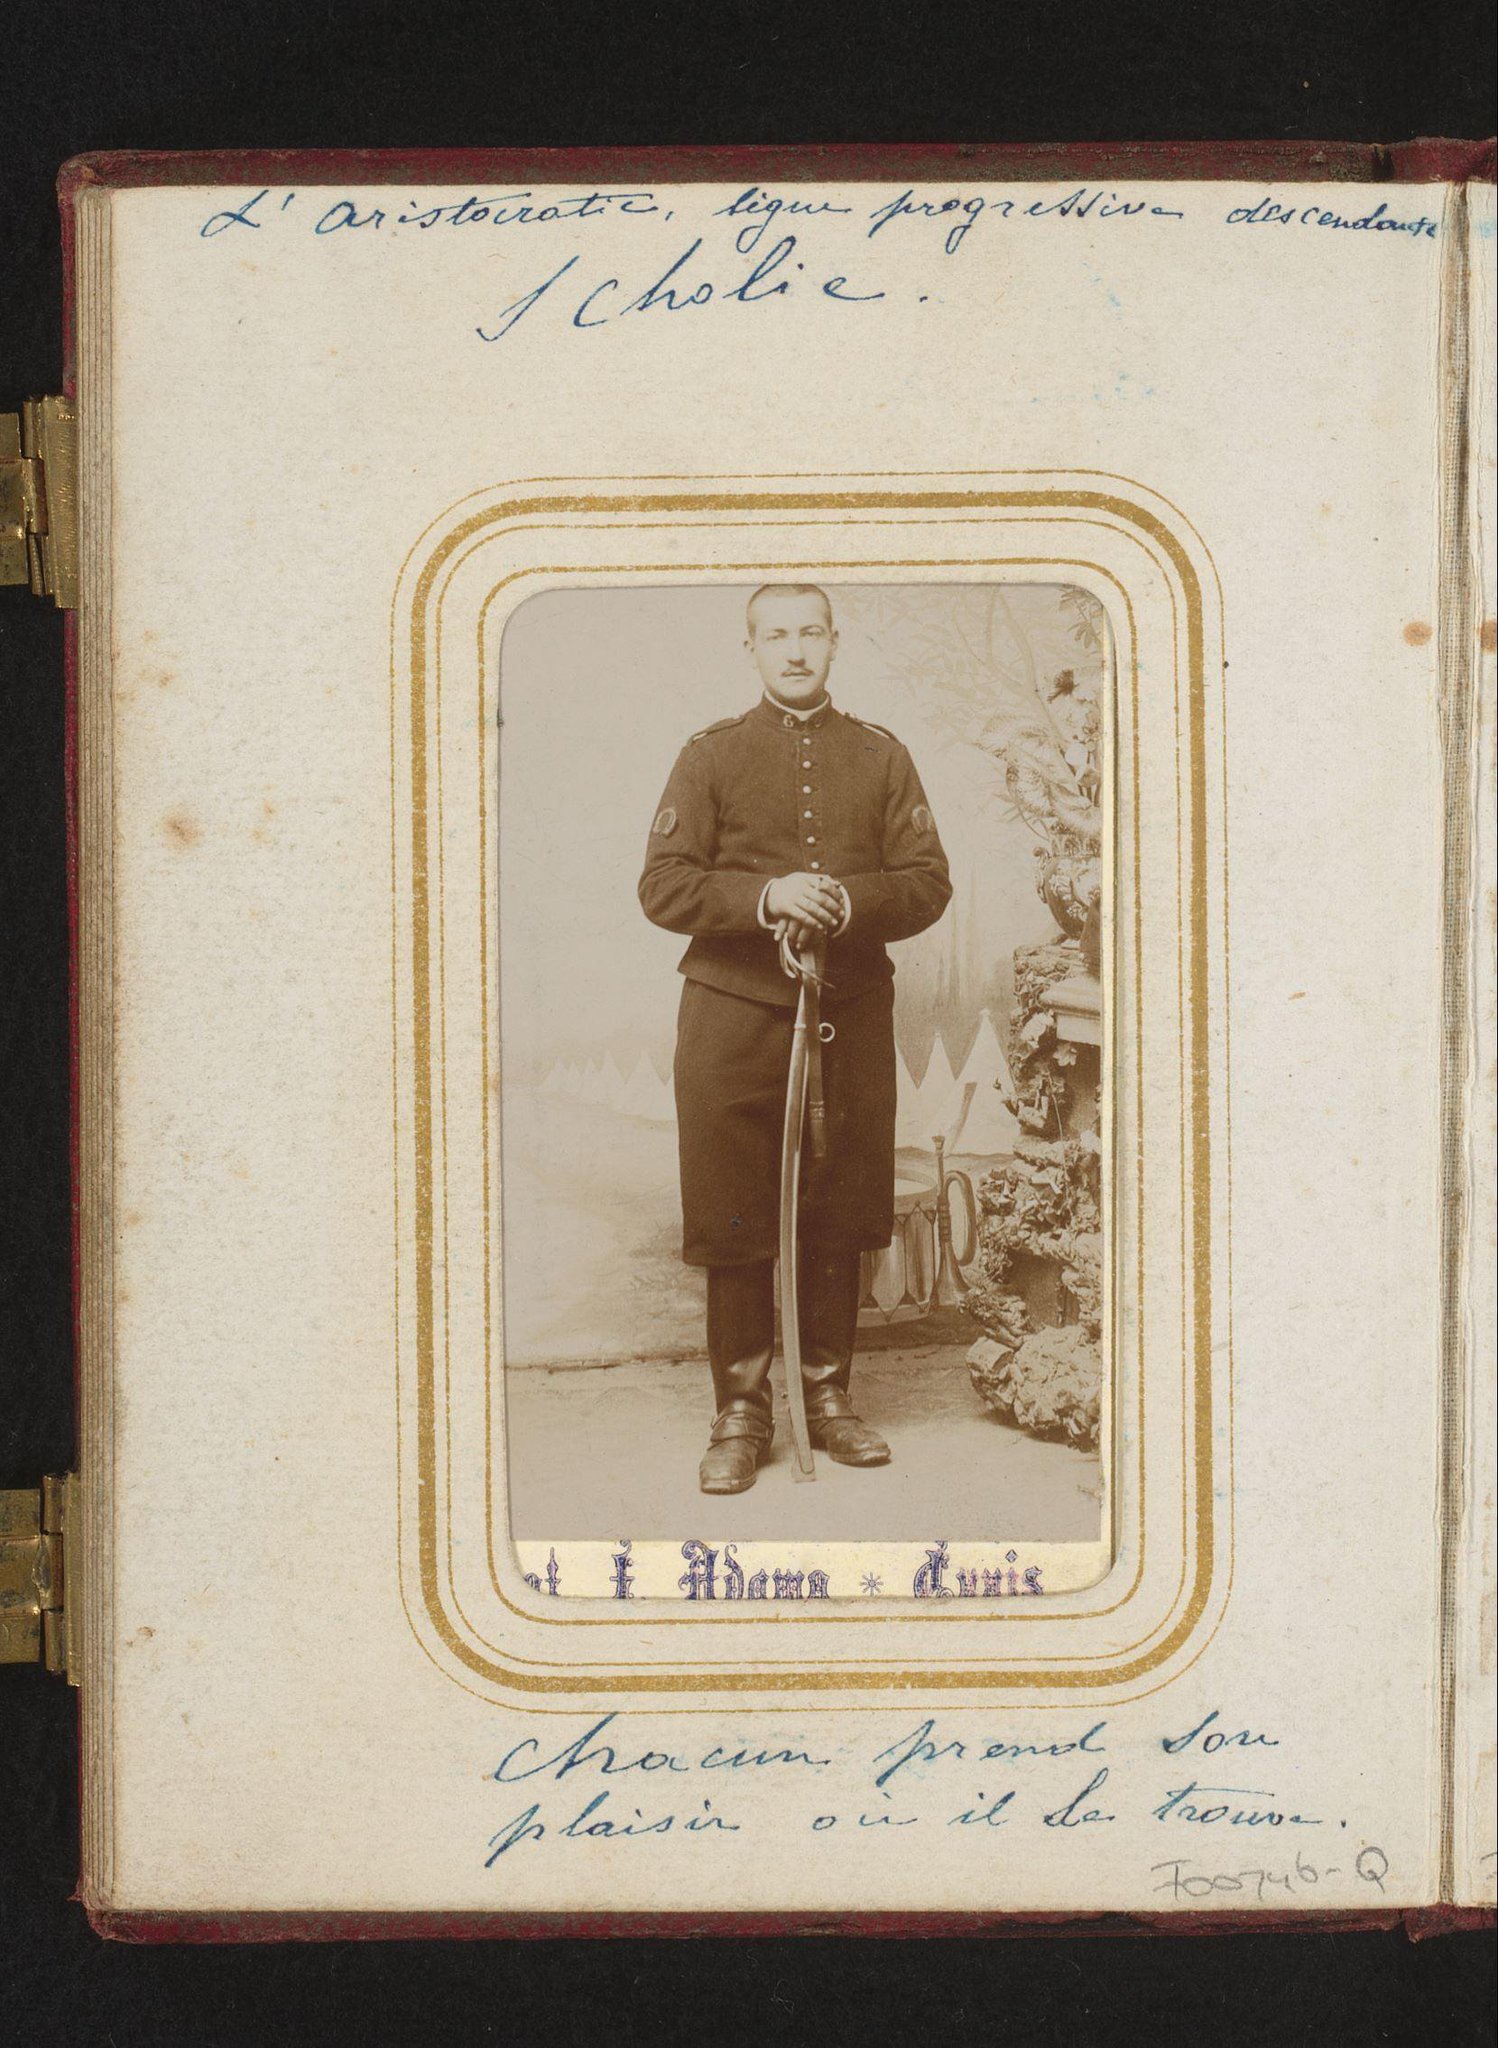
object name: carte de visite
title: Portret van een man in uniform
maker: j. adamo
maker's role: fotograaf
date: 1870-1900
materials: cardboard, photographic support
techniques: gelatin silver print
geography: tunis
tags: adult man, historical persons, (military) uniforms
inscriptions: annotation: ‘Chacun prend son plaisir où il de trouve.’, annotation: ‘L'Aristocratie ligne progressive descendante scholie’, inscription: ‘Phot. J. Adamo Tunis/ Rue des Maltais, 10.’